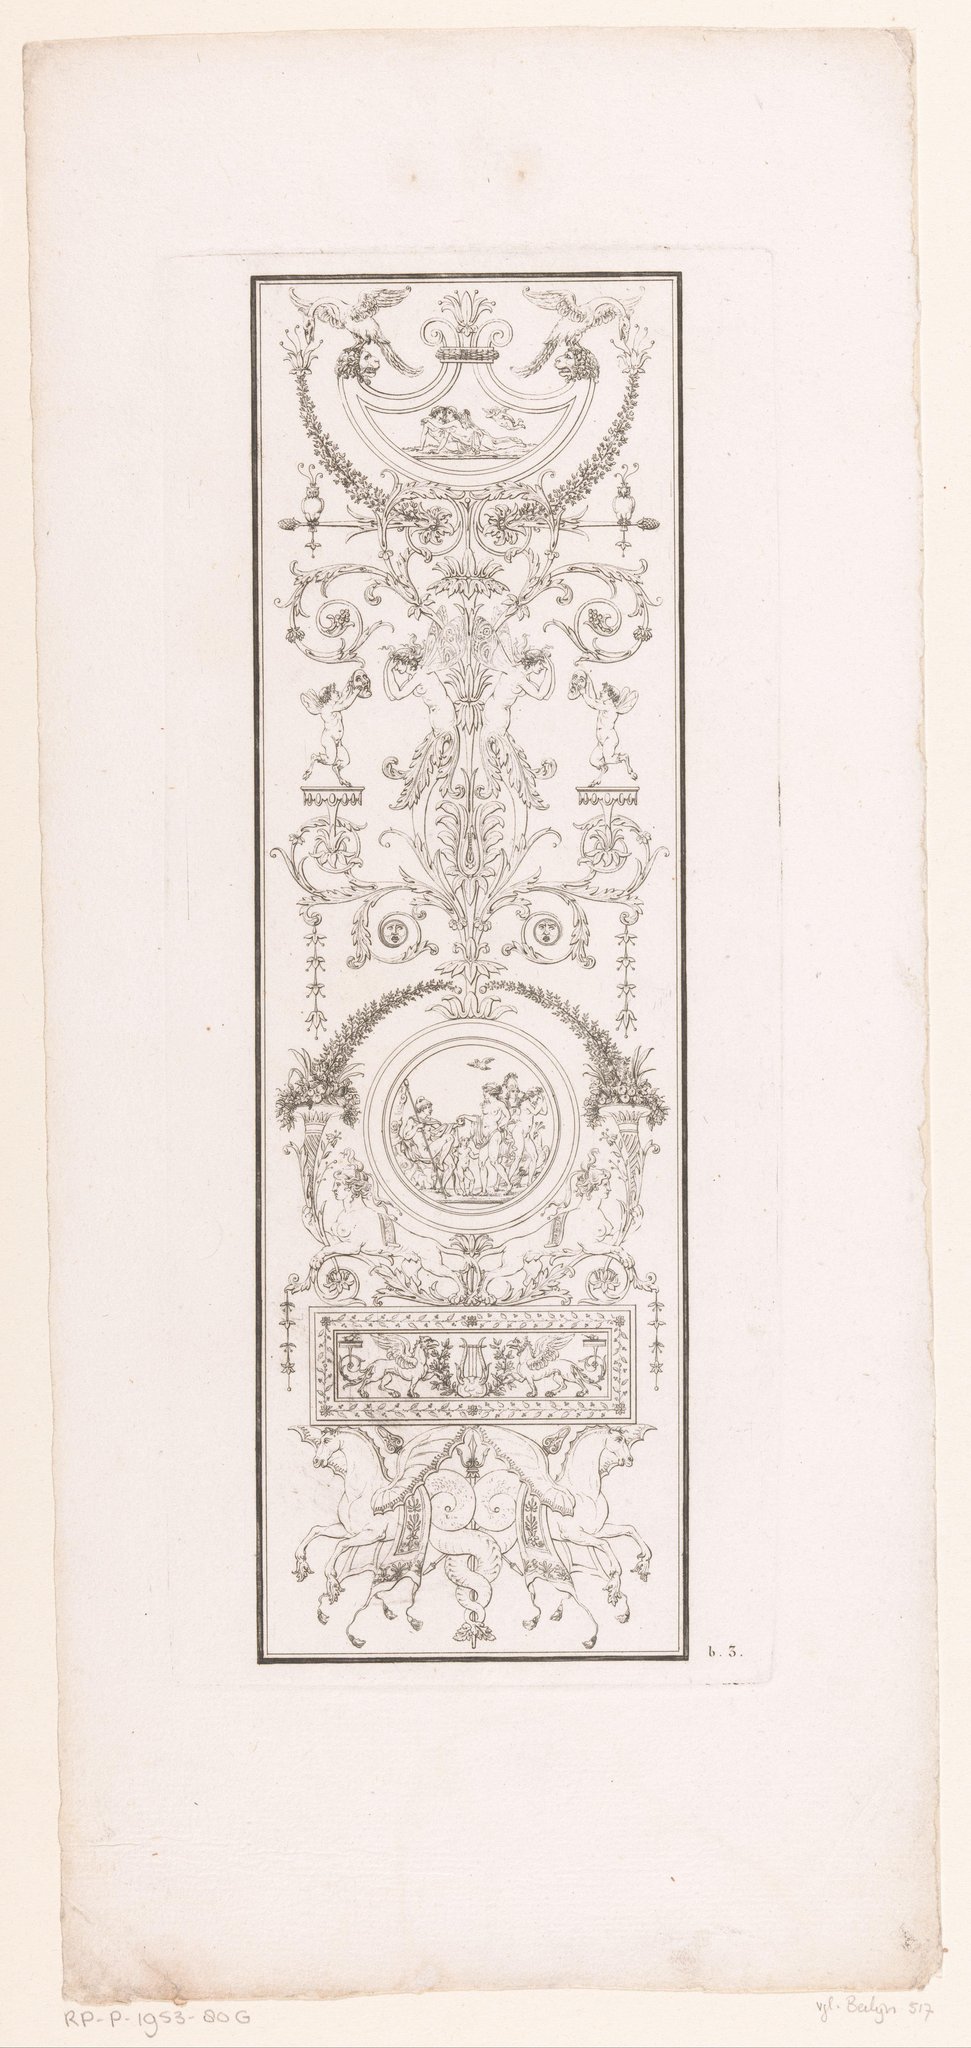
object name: ornament print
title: B Modeles en divers genres (...) Deuxieme Cahier, Arabesques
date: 1803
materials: paper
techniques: engraving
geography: paris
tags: sea-horse, hippocamp, 'hippocampus', (horse/fish) (mythological hybrid monster), ornament ~ arabesque, ornament ~ medallion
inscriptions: collector's mark: Lugt 2228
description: Verticaal paneel met arabesken met aan de bovenzijde twee gelifen, twee gevleugelde kinderen op bokkenpoten met maskers en twee gevleugelde halffiguren. Daaronder een rond medaillon met het Parisoordeel gedragen door twee sfinxen met hoornen des overvloeds. Aan de onderzijde een paneel met griffioenen gedragen door twee hippocampi.